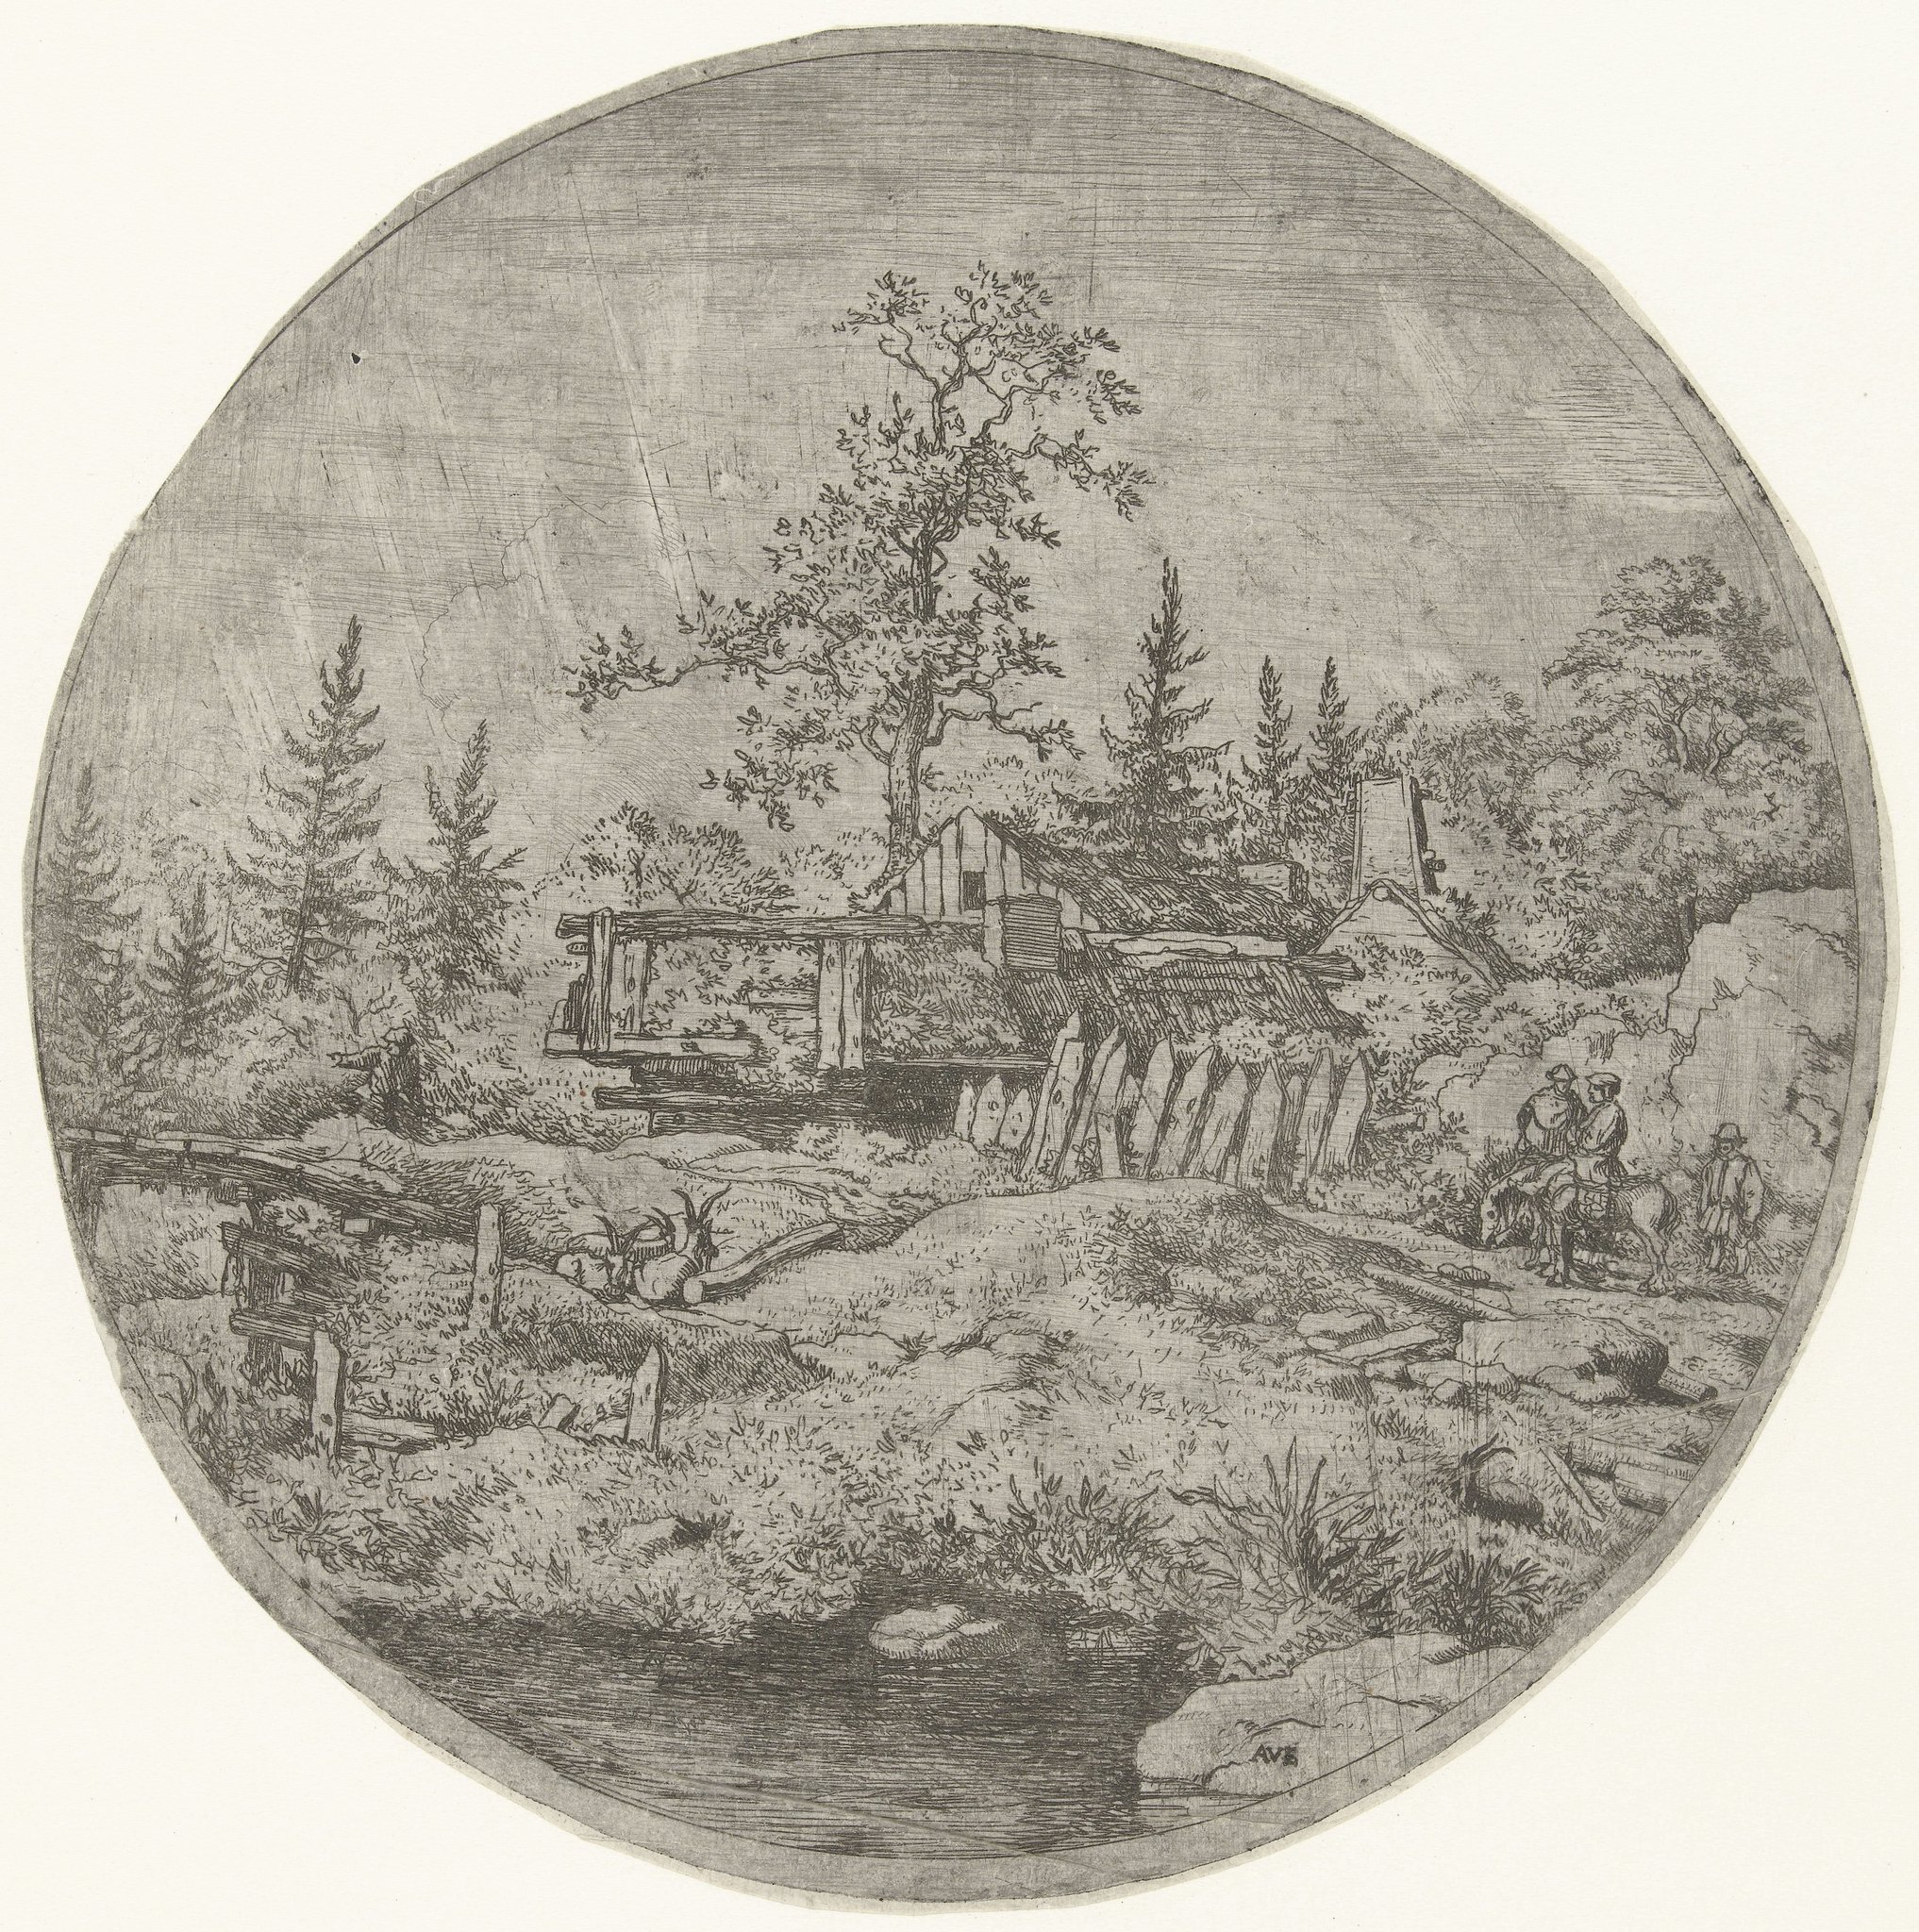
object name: print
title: Landschap met houten brug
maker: allaert van everdingen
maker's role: draughtsman, painter, print maker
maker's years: 1621-1675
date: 1651-1675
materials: paper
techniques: etching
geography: netherlands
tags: landscapes (+ landscape with figures, staffage)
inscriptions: collector's mark: Lugt 2760, collector's mark: Lugt 2228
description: Rond landschap met een gehucht van houten gebouwen en een pad waarop een man te paard en twee voetgangers. Verderop bij een brug een vierde man.